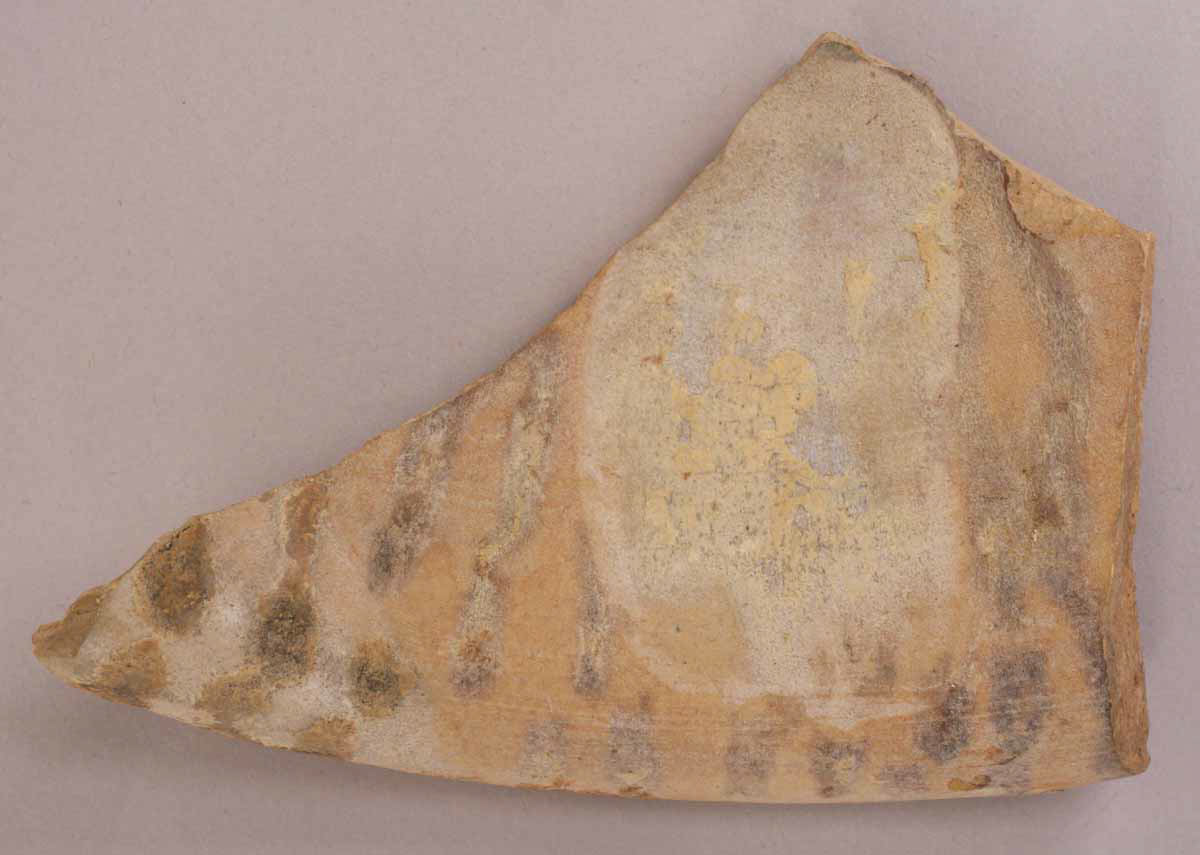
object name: fragment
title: Ceramic Fragment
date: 701-900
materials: earthenware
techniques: glazing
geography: iraq